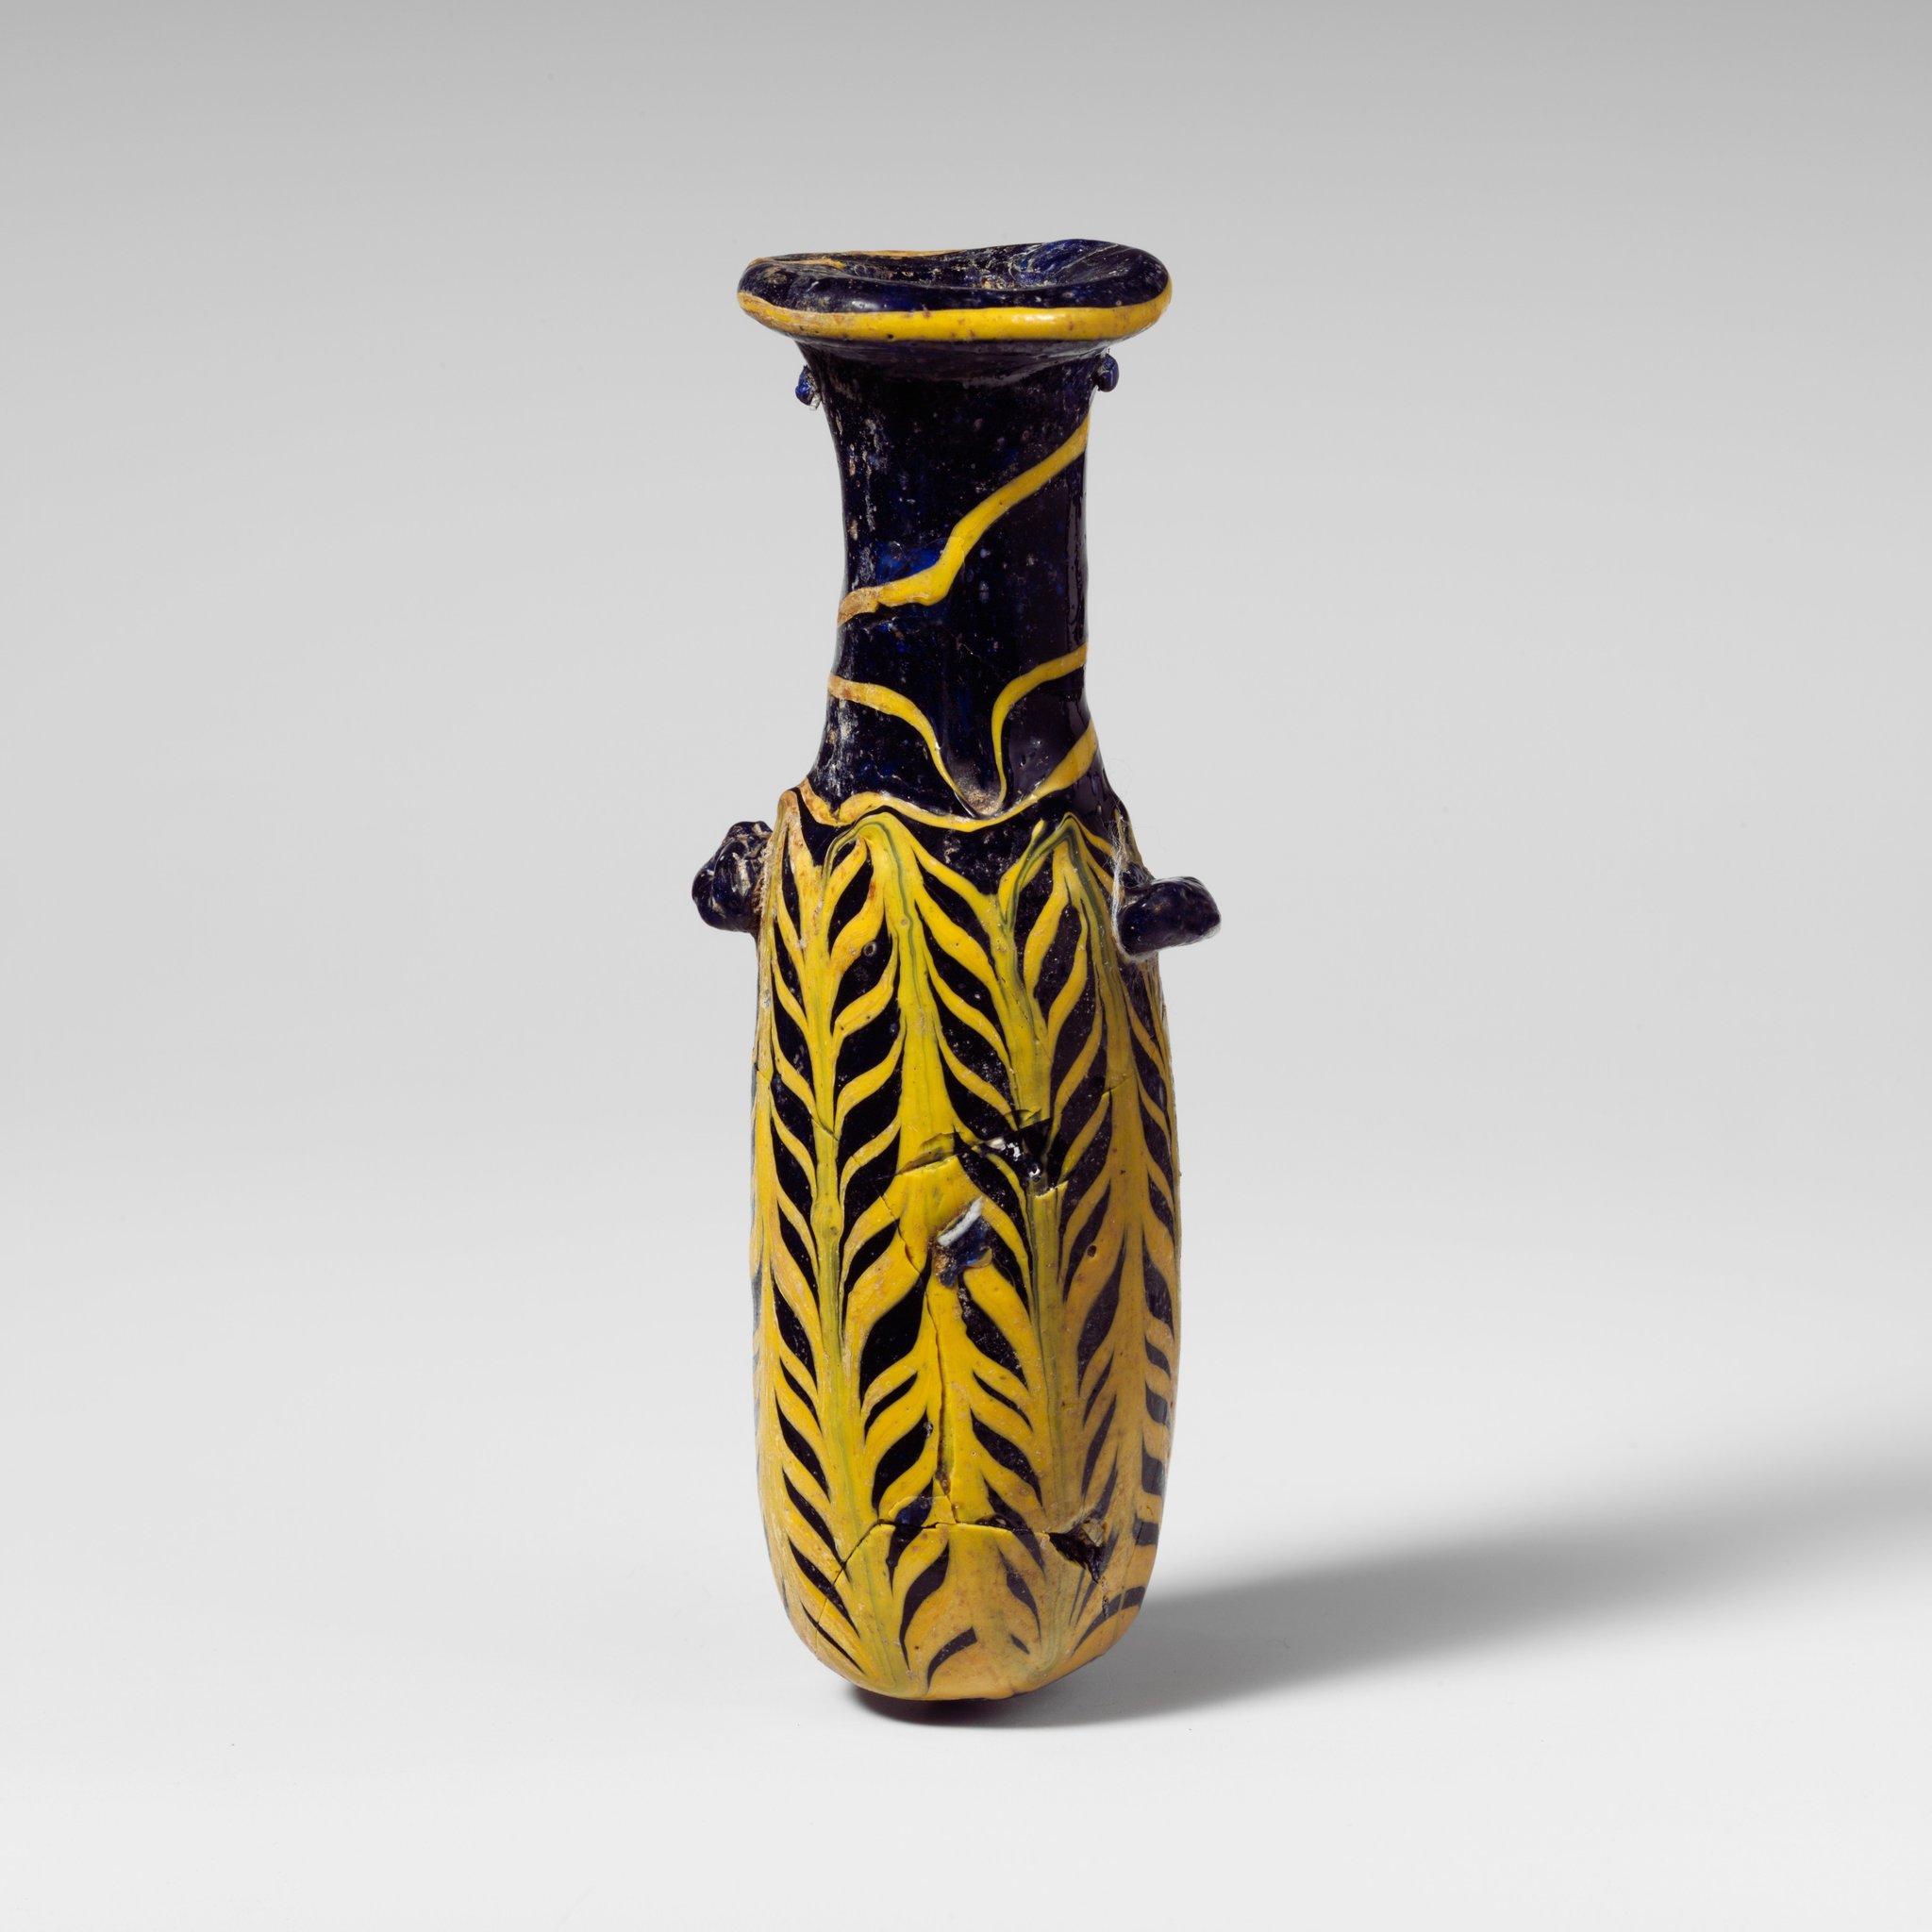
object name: alabastron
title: Glass alabastron (perfume bottle)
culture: greek, eastern mediterranean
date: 200-1 BCE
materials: glass